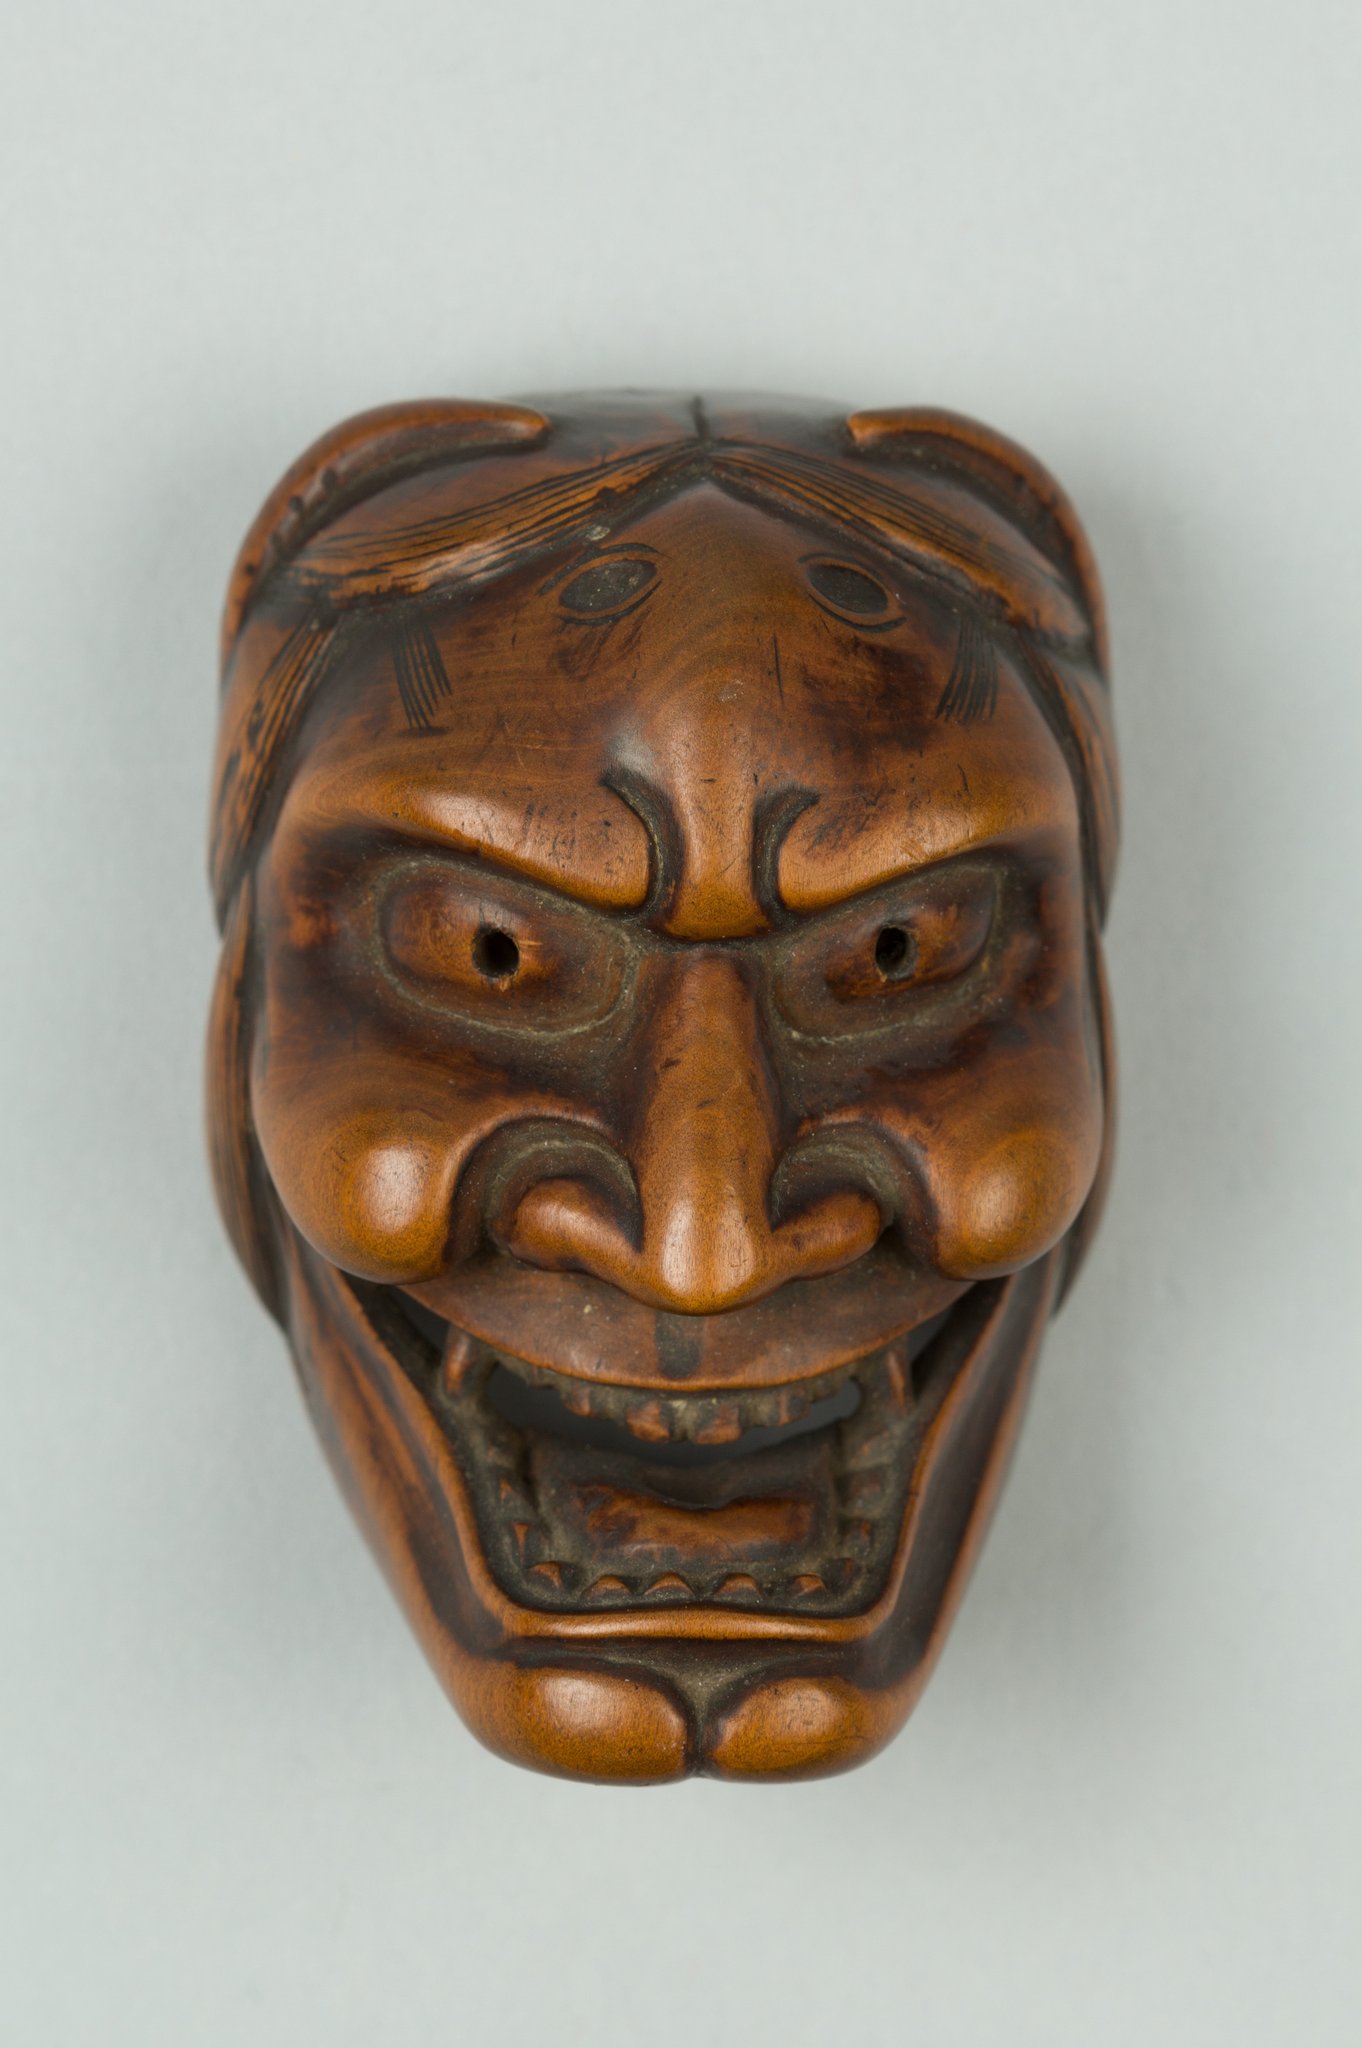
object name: netsuke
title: Netsuke of Noh Mask: Hannya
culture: japanese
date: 1701-1800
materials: wood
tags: masks